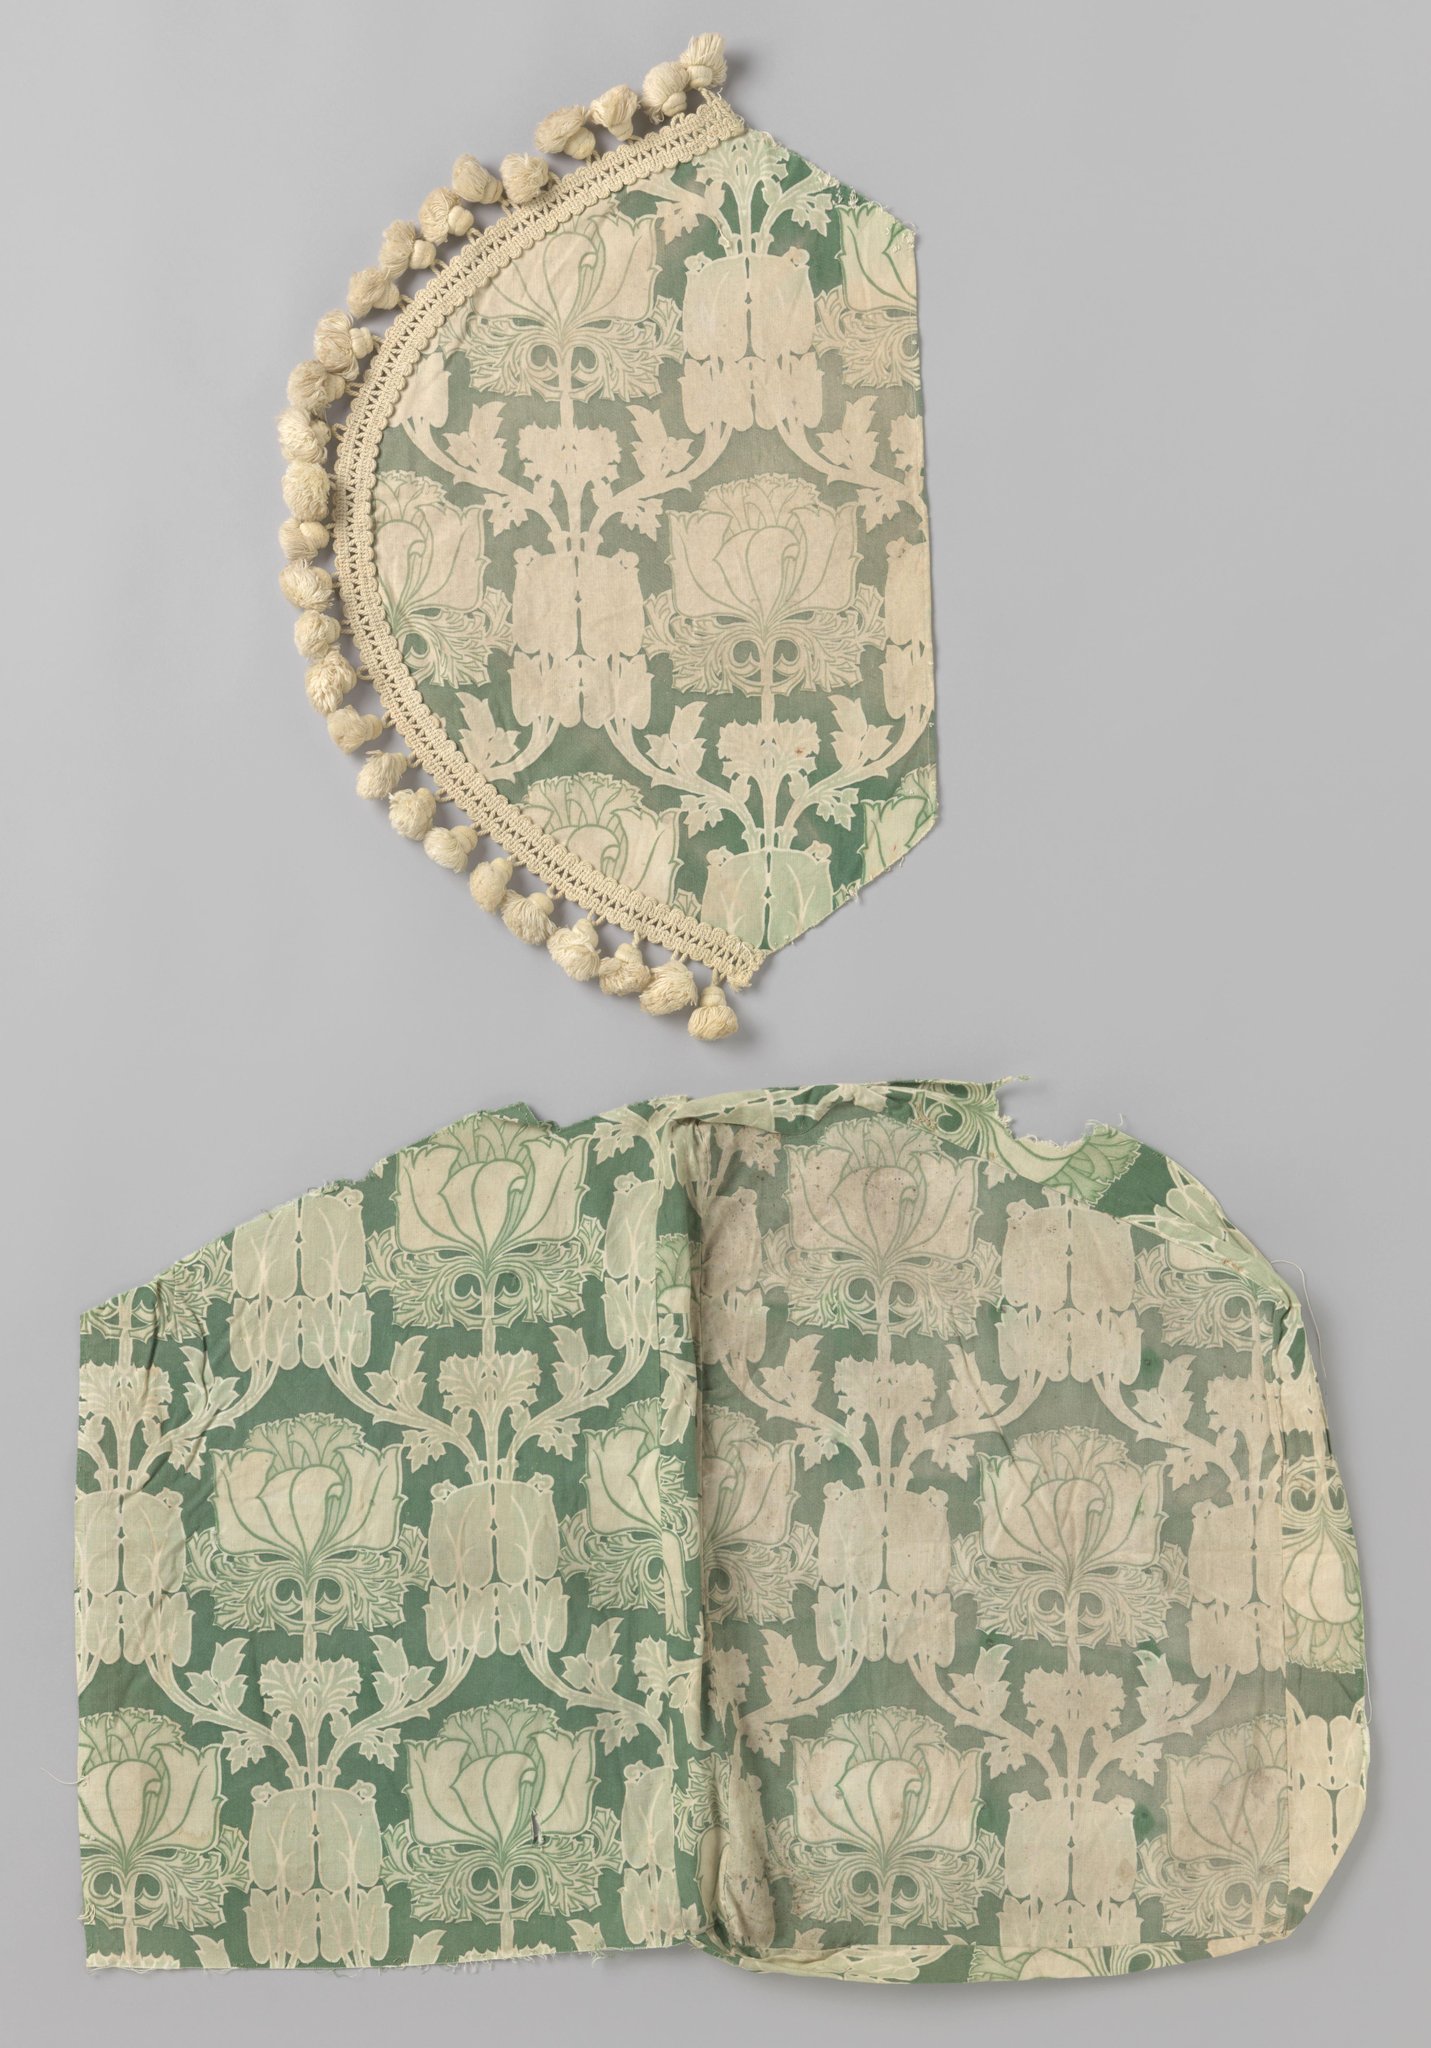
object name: interieuronderdeel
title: Twee overtrekken voor rugkussens voor tuinbank van groen-wit bedrukte zware katoen met patroon van iris- of leliebloemen in spitsovale opgroeiende stengels in de stijl van William Morris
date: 1890-1900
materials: cotton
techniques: printing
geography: england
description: Twee overtrekken voor rugkussens voor tuinbank van groen-wit bedrukte zware katoen met patroon van iris- of leliebloemen in spitsovale opgroeiende stengels in de stijl van William Morris. Patroon: grote symmetrische irissen of lelies met groen omlijnde witte en lichtgroene bloembladeren op flesgroene grond. Zij staan in verspringende rijen binnen spitsovaal opgaande dubbele wit omlijnde stengels met tweemaal een drieblad op de knooppunten.